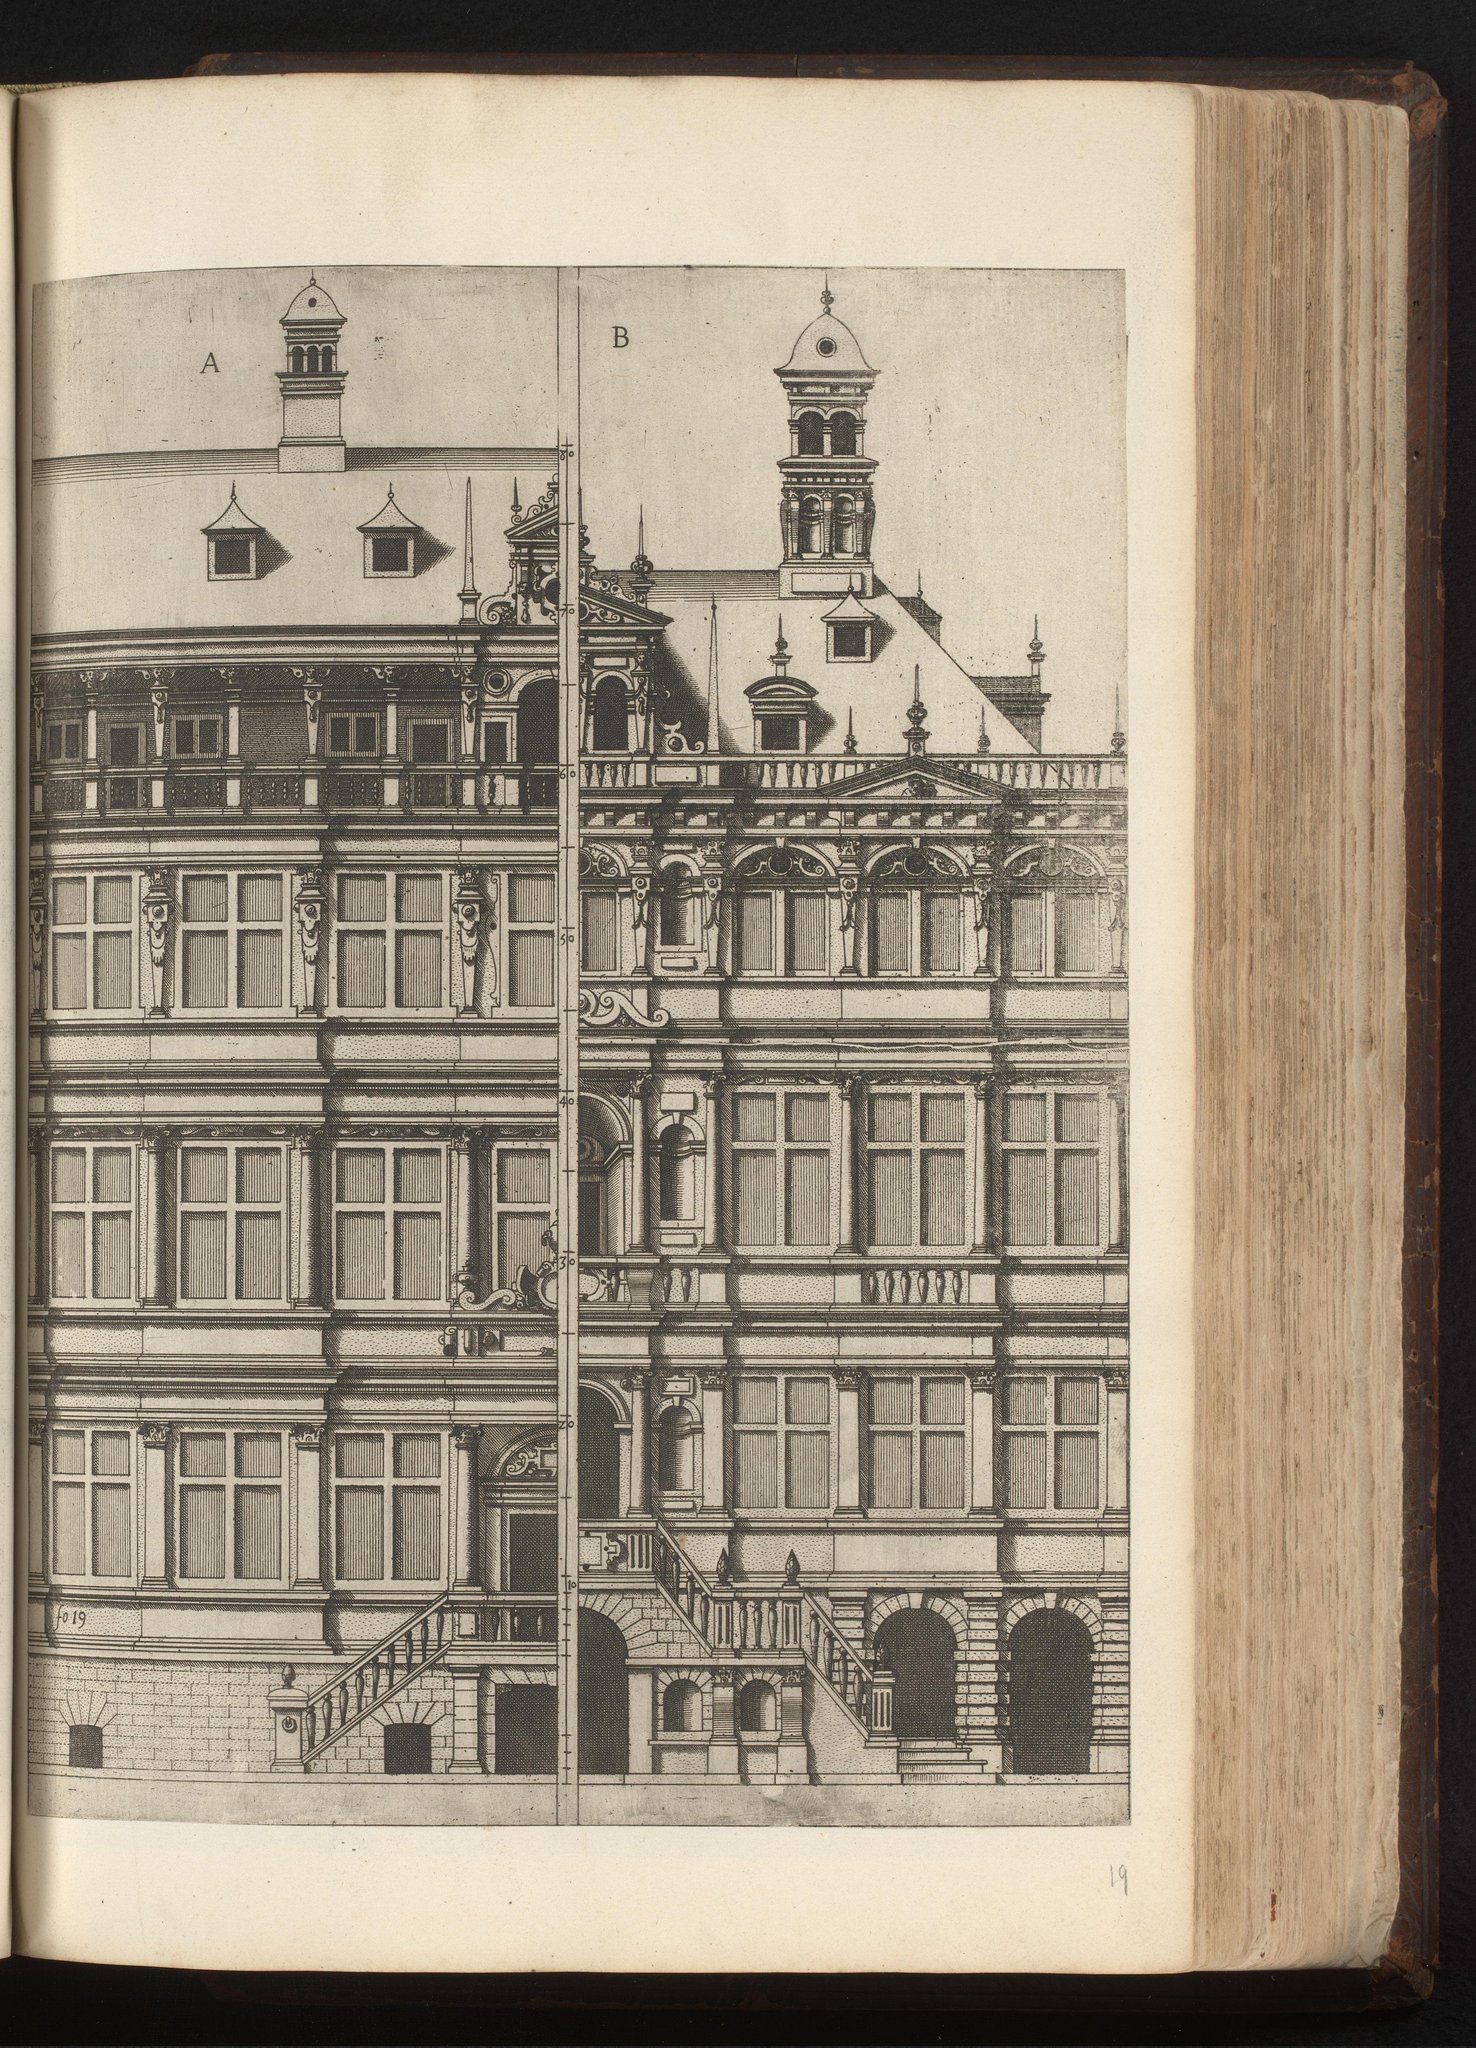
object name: print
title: Gevels in de Korinthische orde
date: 1581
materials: paper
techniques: engraving, etching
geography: antwerp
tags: civic architecture; edifices; dwellings, corinthian order ~ architecture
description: Prent uit: Vredeman de Vries, Hans. Architectura oder Bauung der Antiquen auss dem Vitruvius, waellches sein funff Collummen orden, (...). Antwerpen: Gerard de Jode en Gerard Smits, 1581. Prent eerder verschenen in de 1577-editie.